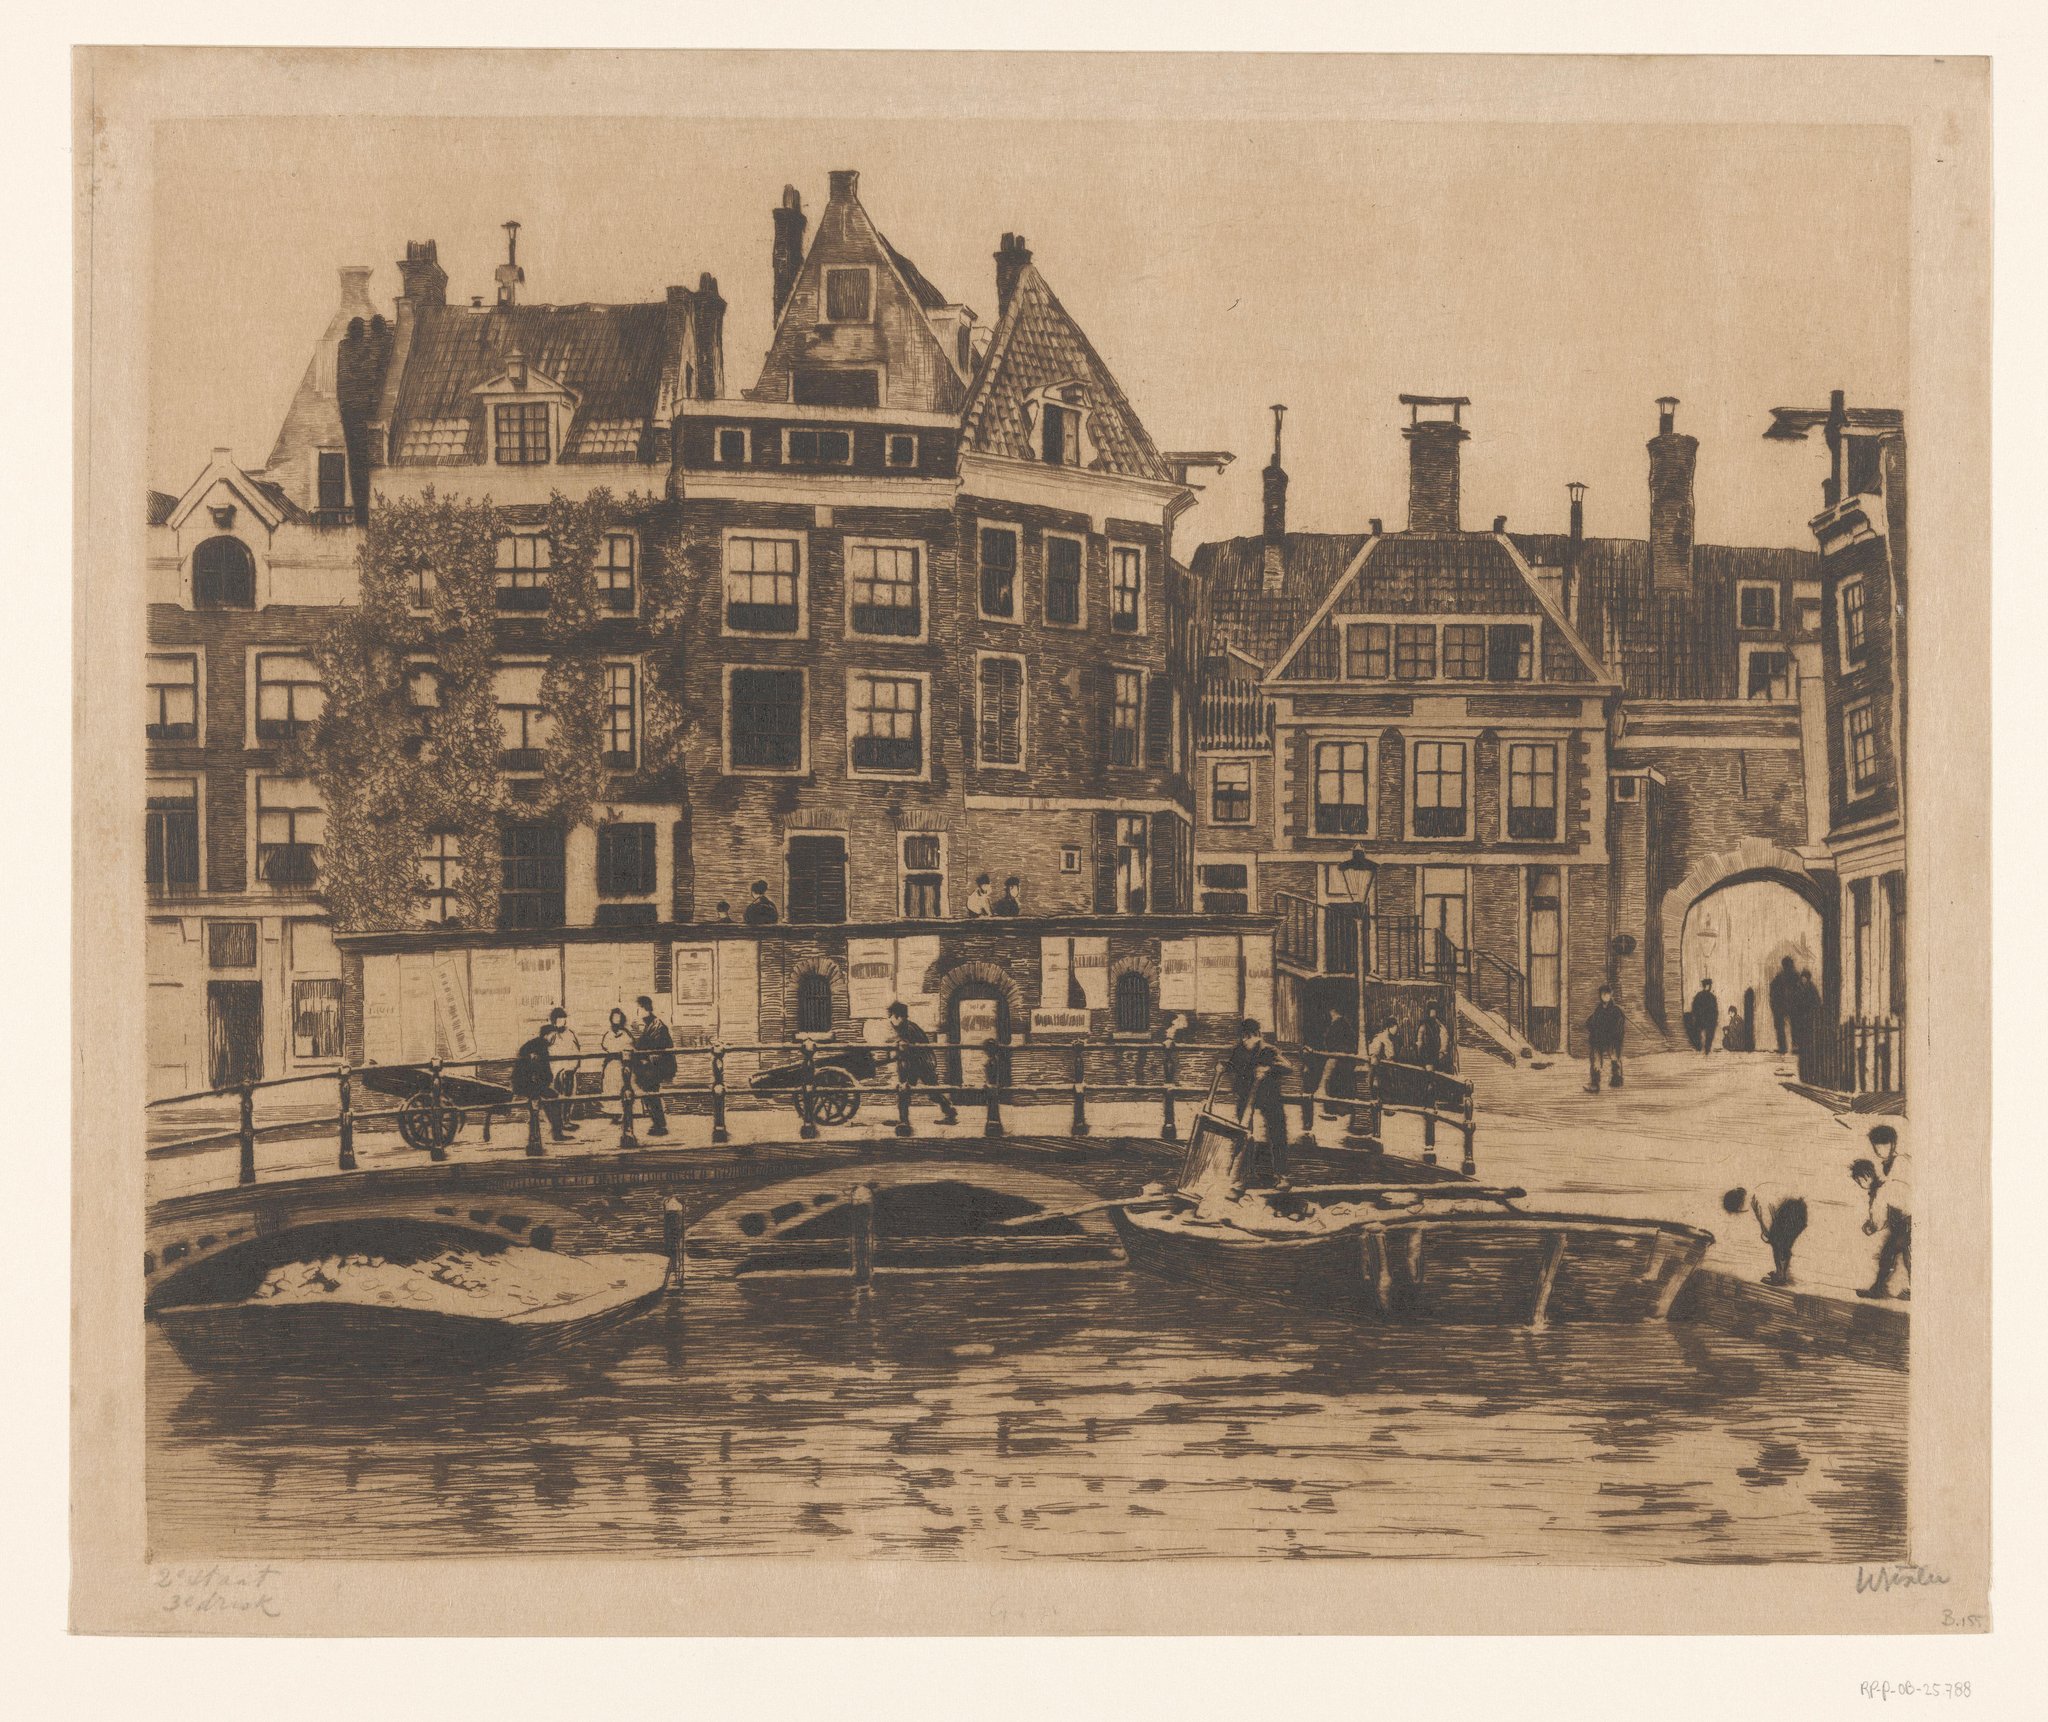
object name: print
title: Gezicht op het Beurspleintje in Amsterdam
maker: willem witsen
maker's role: draughtsman, painter, print maker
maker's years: 1860-1923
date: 1911-1912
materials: paper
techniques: etching, intaglio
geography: amsterdam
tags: urban housing, canals, waters (in city), boat propelled by man or animal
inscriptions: collector's mark: Lugt 2228, inscription: ‘2e staat 3e druk’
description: Gezien vanuit het Rokin naar het noorden. Links de achtergevels van de huizen aan de Vijgendam. Rechts het Beurspleintje, het Beurspoortje en de uitstekende gevel van Rokin 3. Tegenwoordig geheel veranderd.